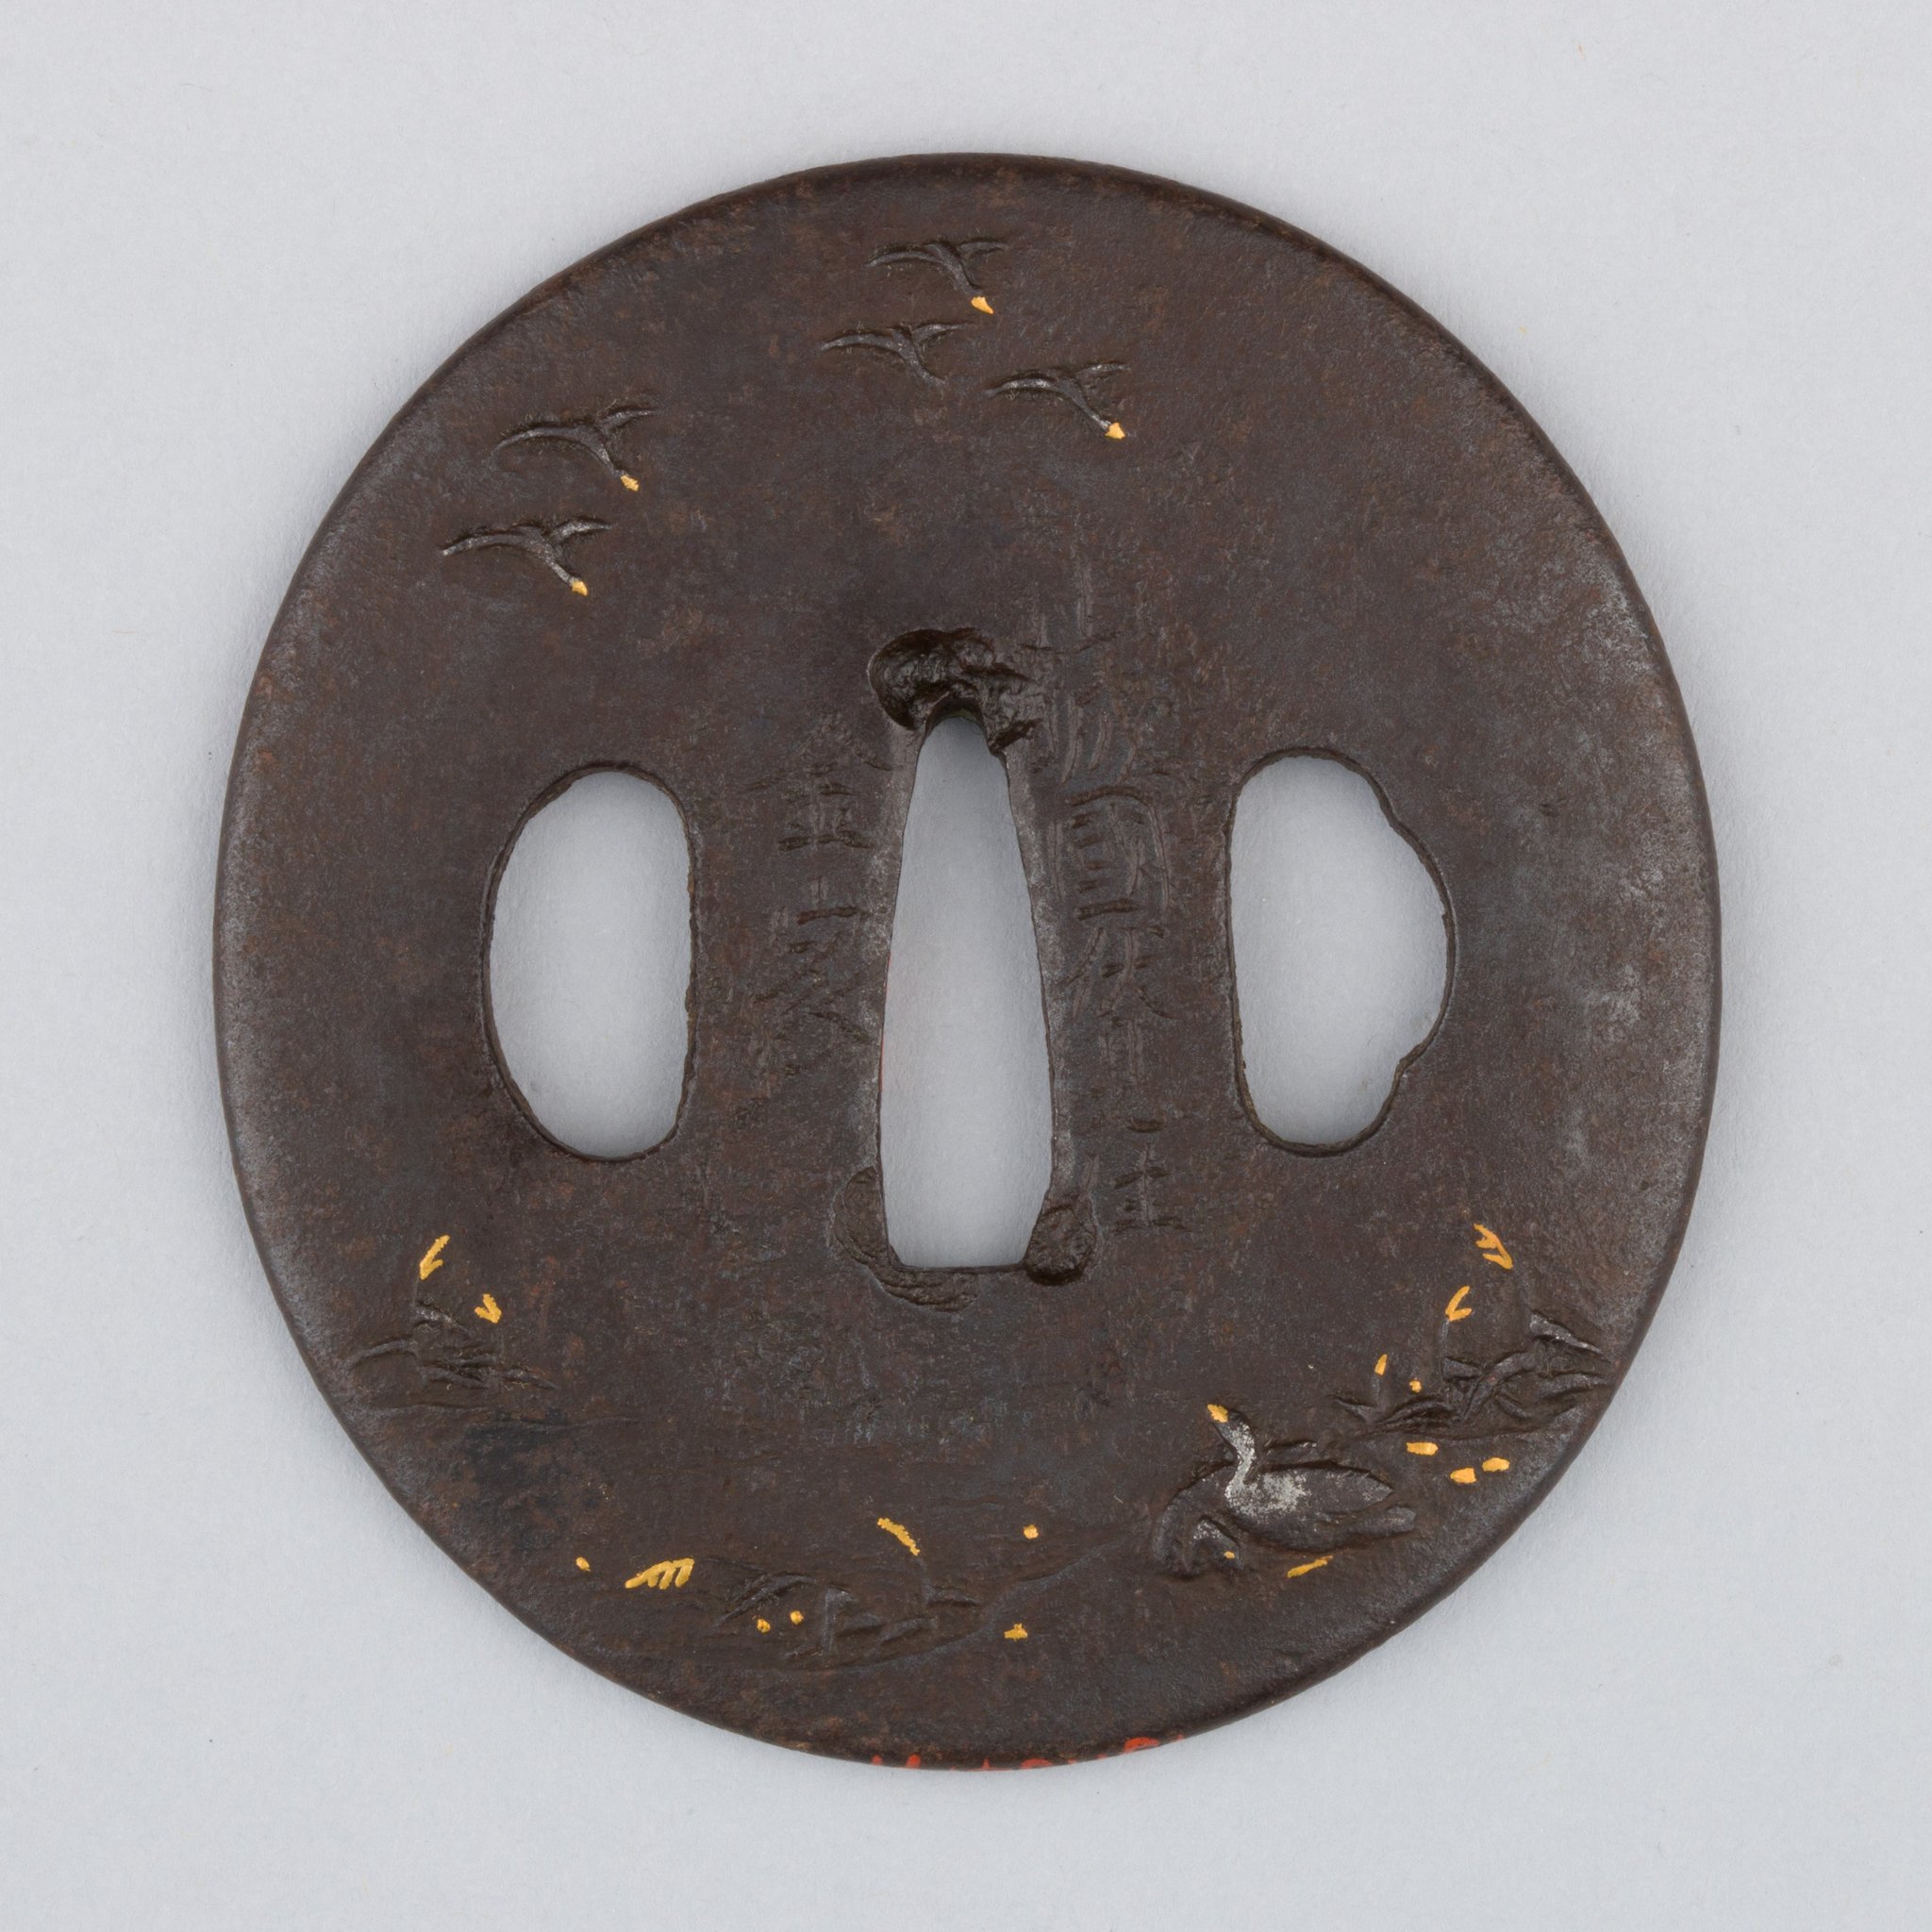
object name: sword guard tsuba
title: Sword Guard (Tsuba)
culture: japanese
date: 1615-1868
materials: copper, iron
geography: japan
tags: geese